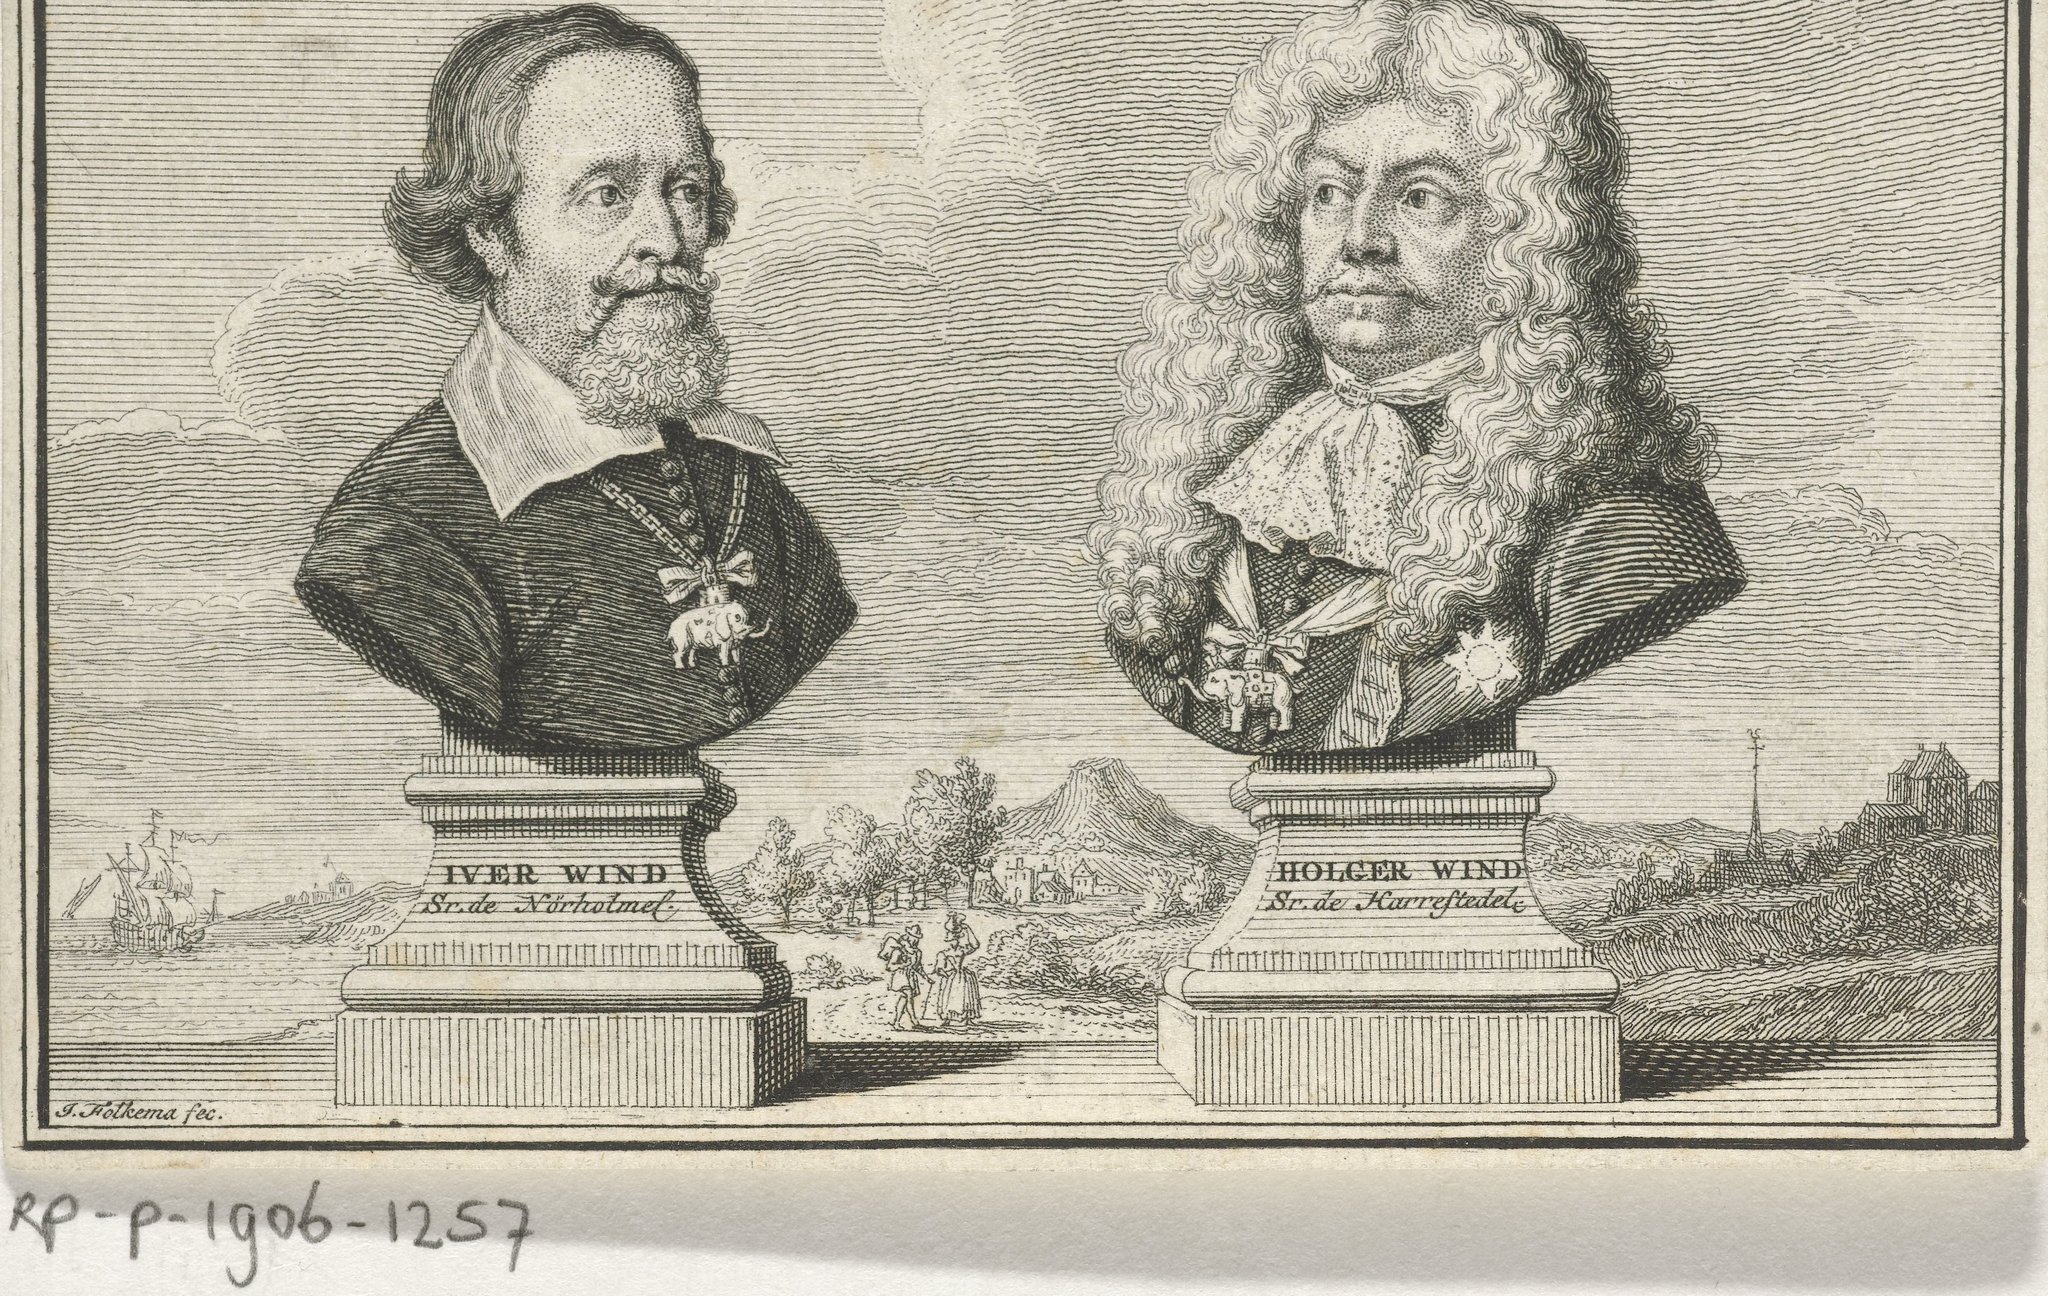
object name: print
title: Borstbeelden van Iver en Holger Wind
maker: jacob folkema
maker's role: draughtsman, print maker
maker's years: 1692-1767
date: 1702-1767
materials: paper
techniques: etching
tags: orde van de olifant, ivar wind, holger wind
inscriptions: collector's mark: Lugt 2228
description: Twee borstbeelden van Iver en Holger Wind. Opun borst hangt een olifantje, symbool van de Orde van de Olifant.